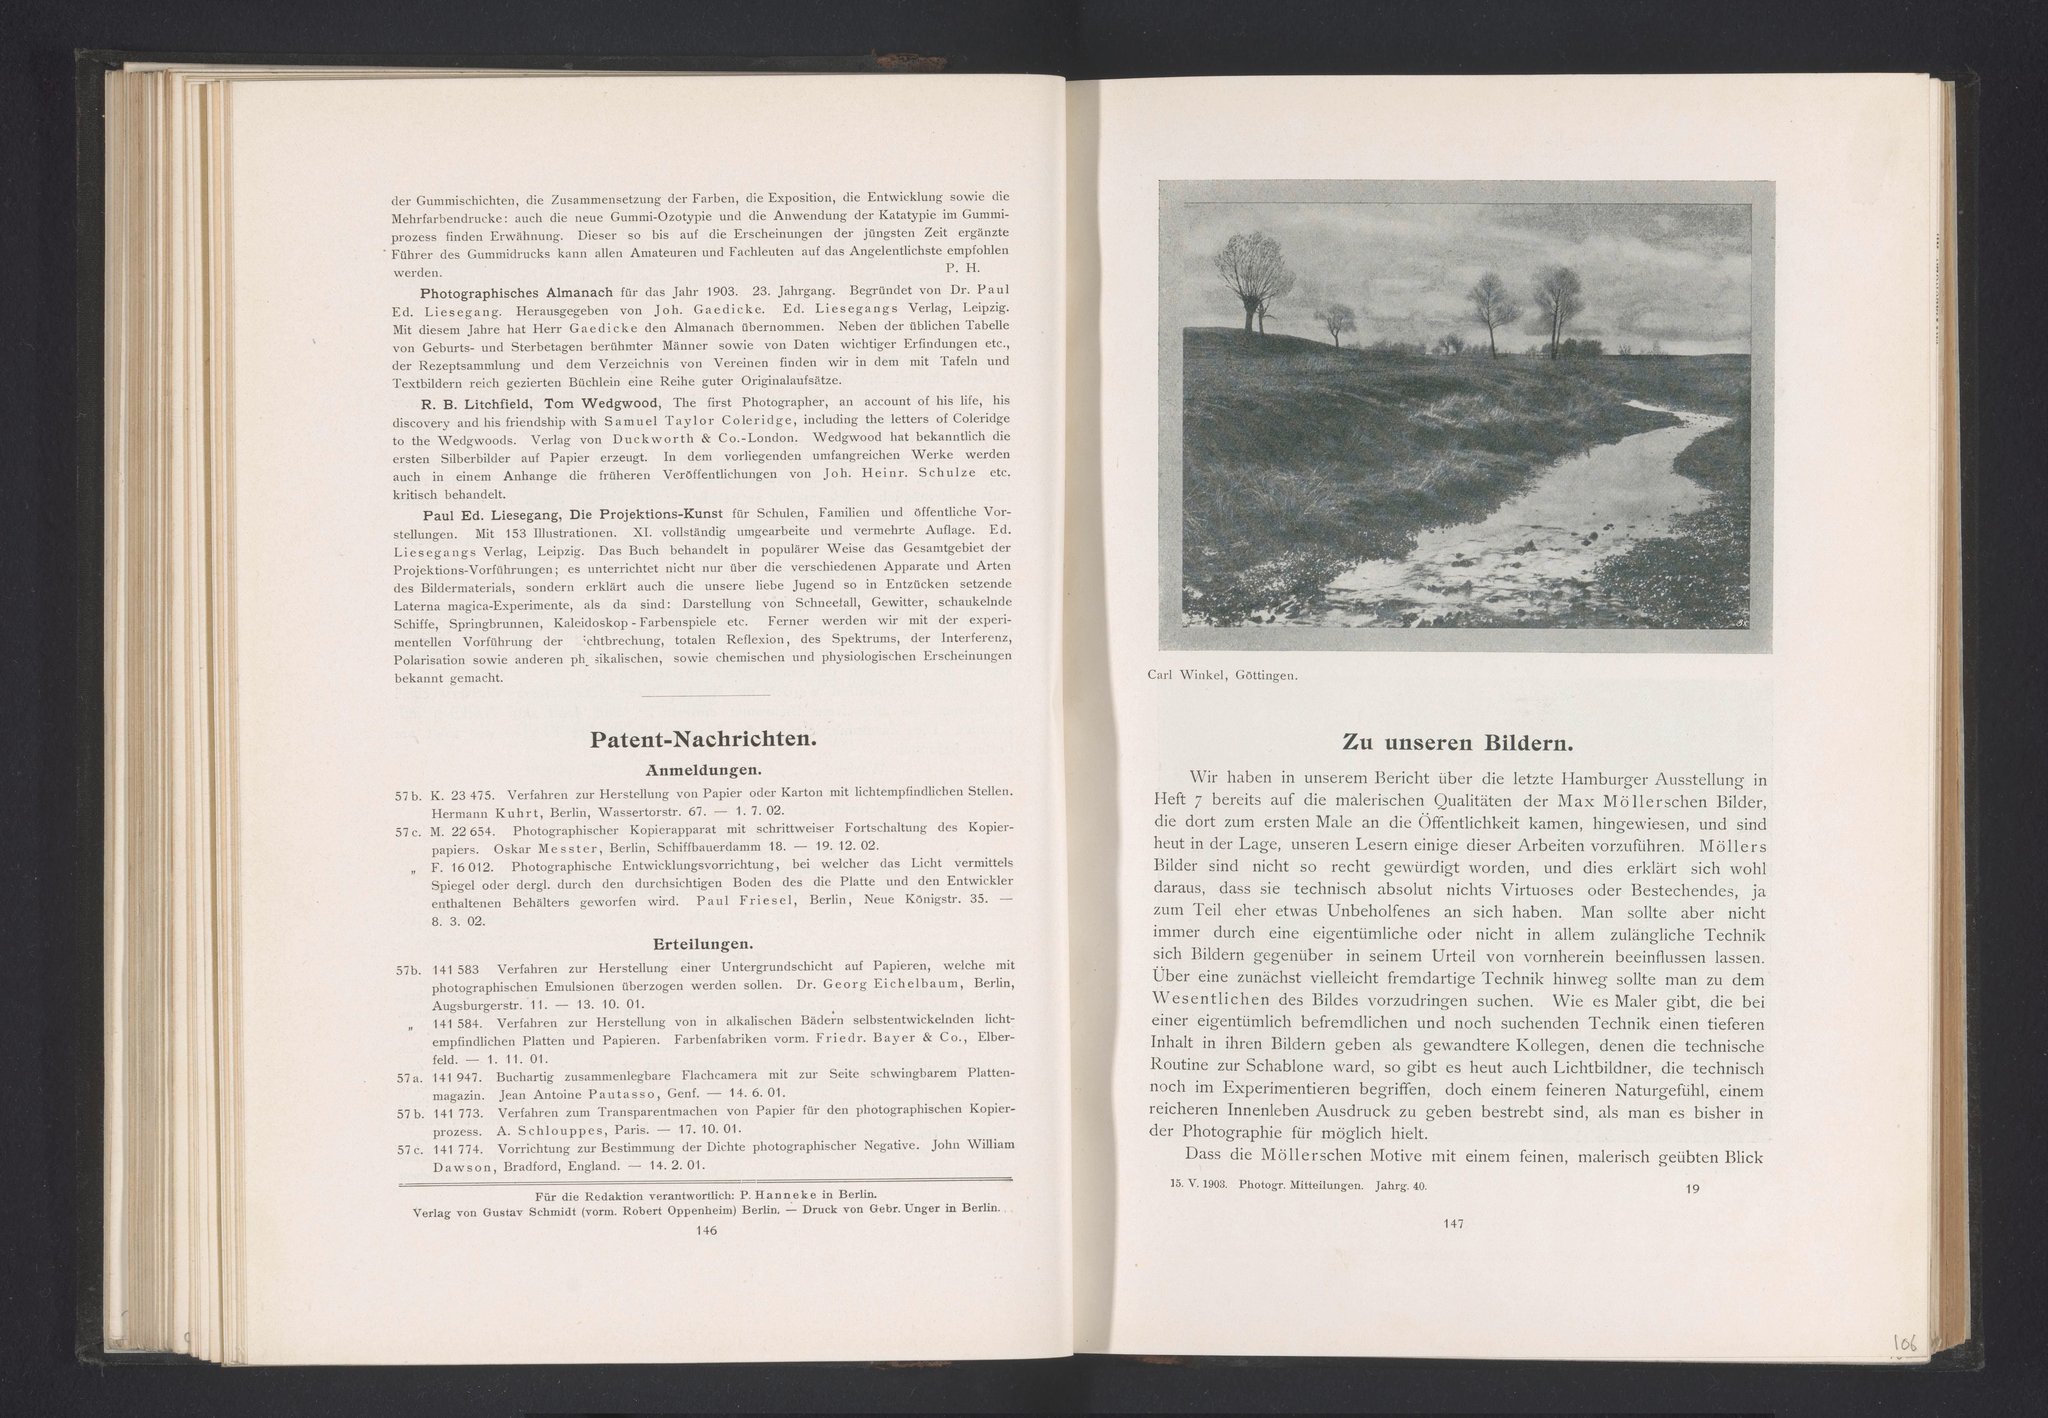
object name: page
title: Landschap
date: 1898-1903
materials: paper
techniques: autotype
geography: gottingen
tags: landscapes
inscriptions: monogram: ‘BX’